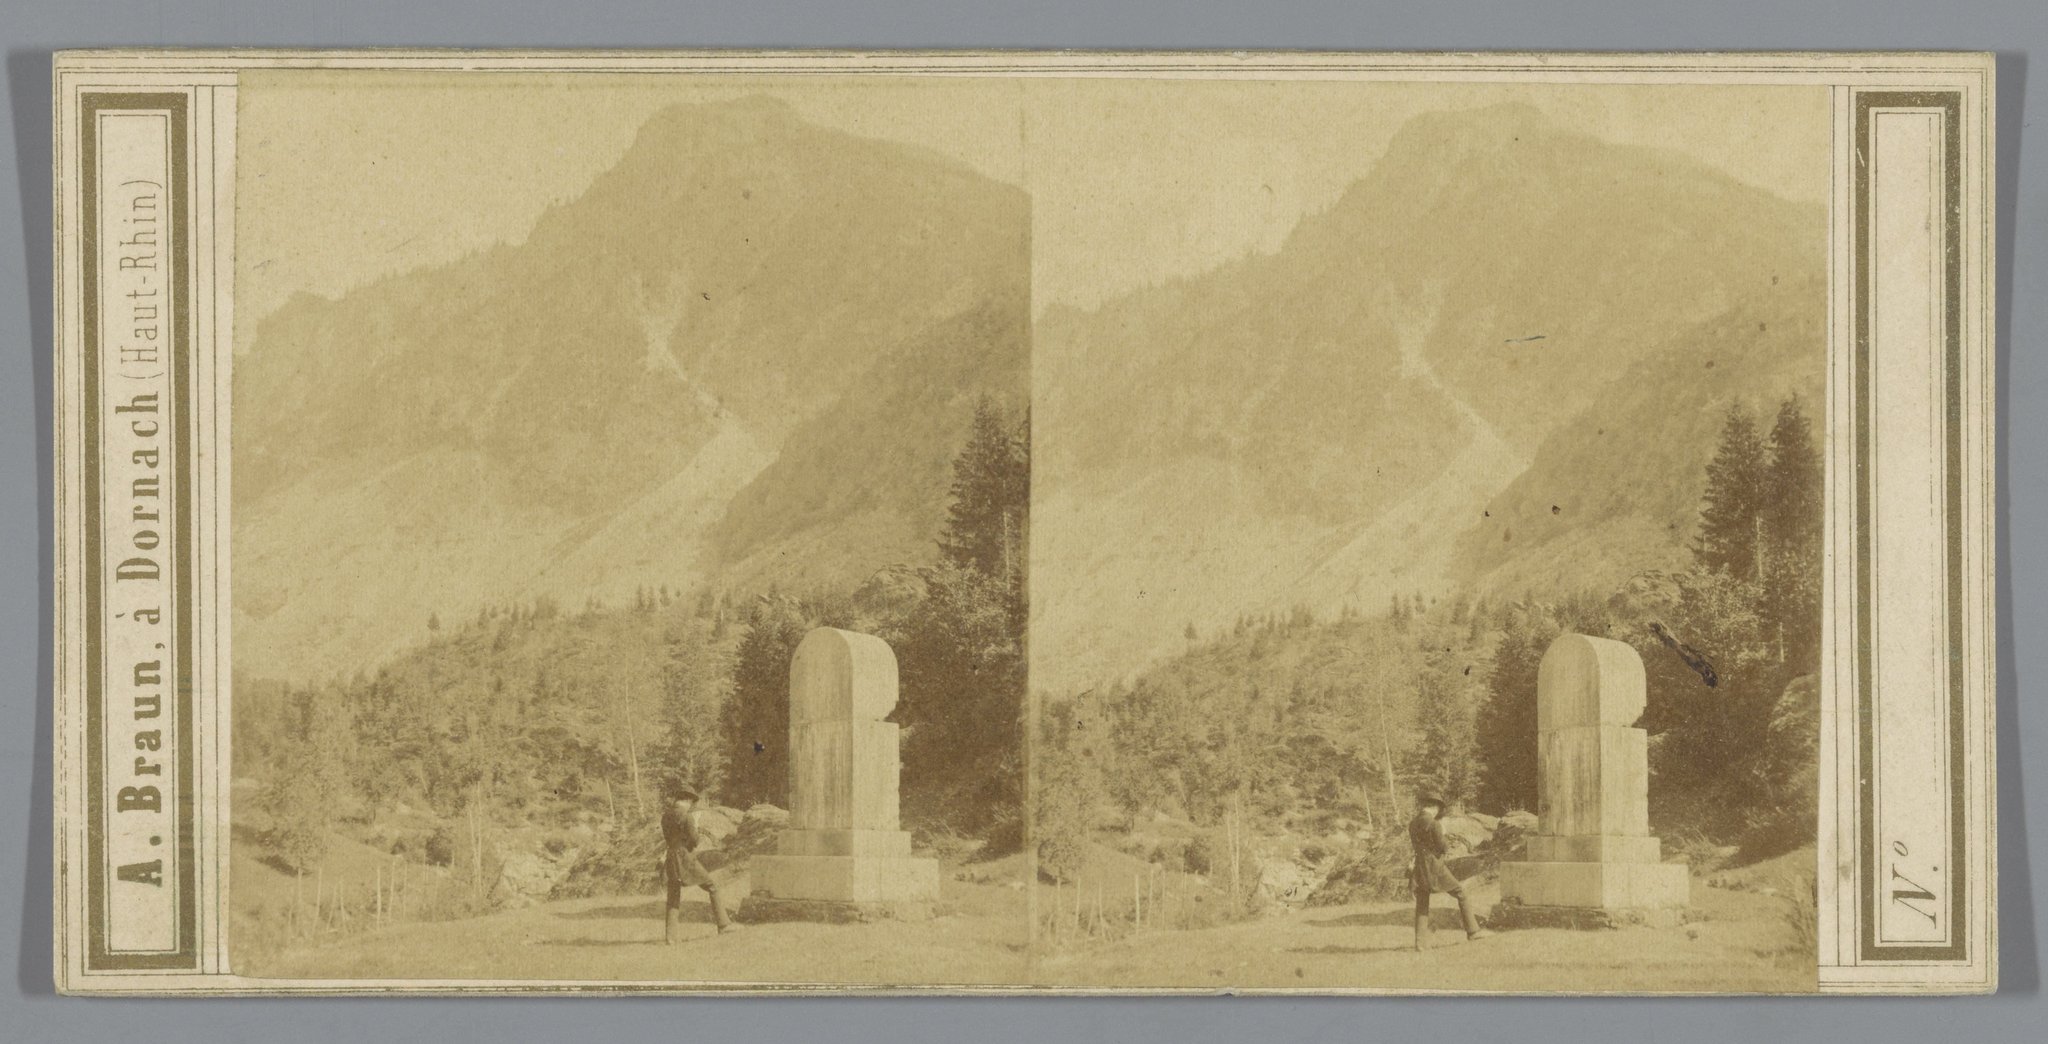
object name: stereograph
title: Monument voor Friedrich August Eschen in Servoz, Frankrijk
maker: Anonymous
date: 1860-1866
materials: cardboard, paper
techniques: albumen print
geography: dornach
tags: monument, statue, mountain meadow, alp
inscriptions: inscription: ‘1,50’, number: ‘768.’